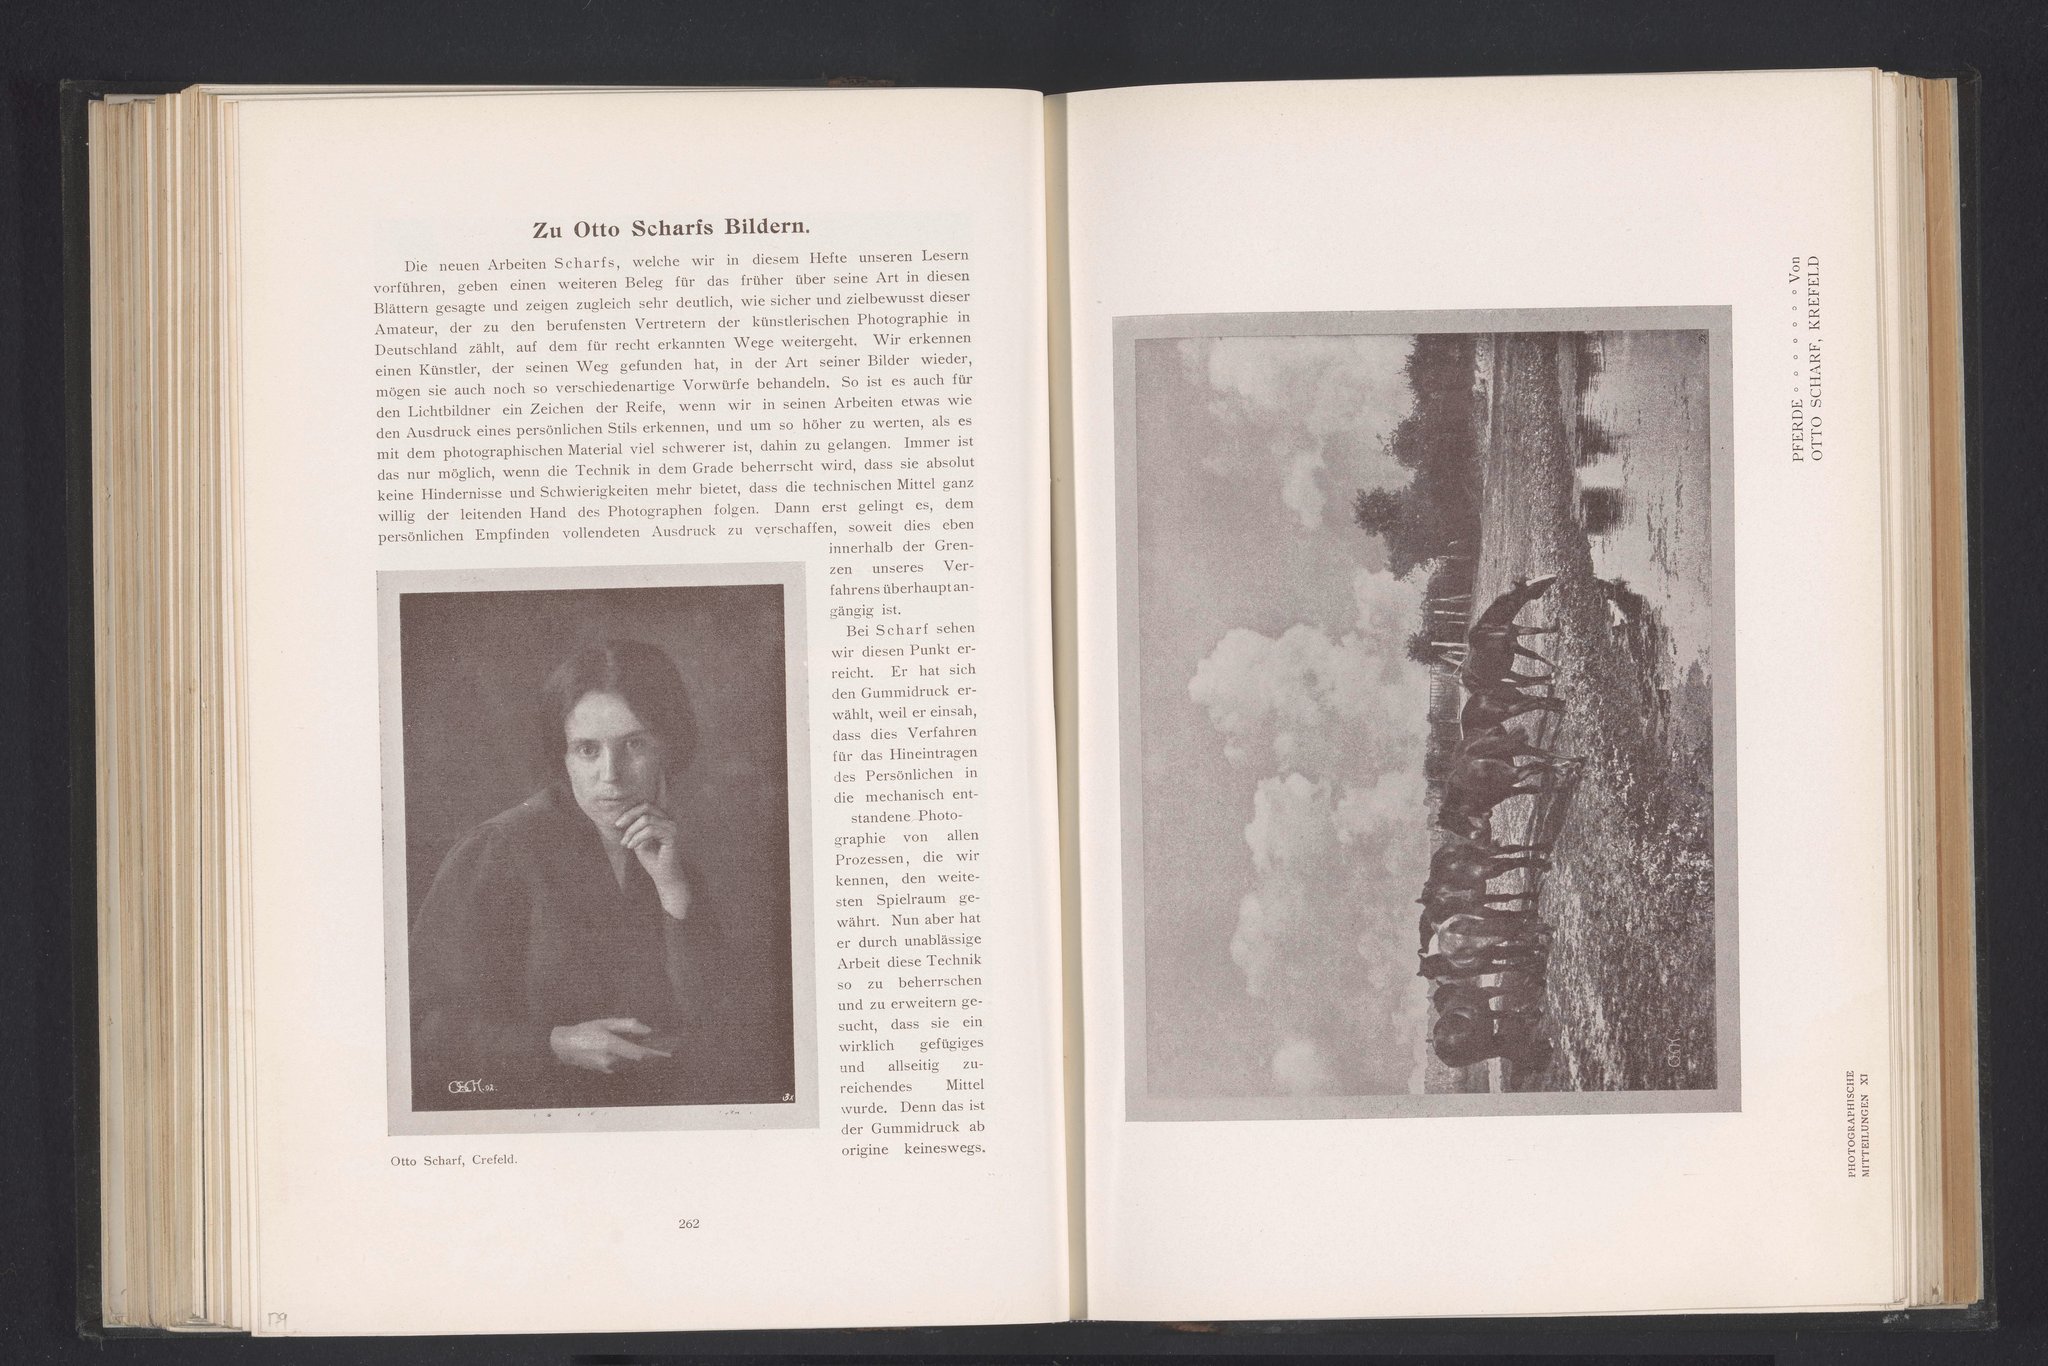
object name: photomechanical print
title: Portret van een onbekende vrouw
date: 1898-1903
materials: paper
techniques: autotype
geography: krefeld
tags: historical persons - bb - woman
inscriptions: monogram: ‘BX’